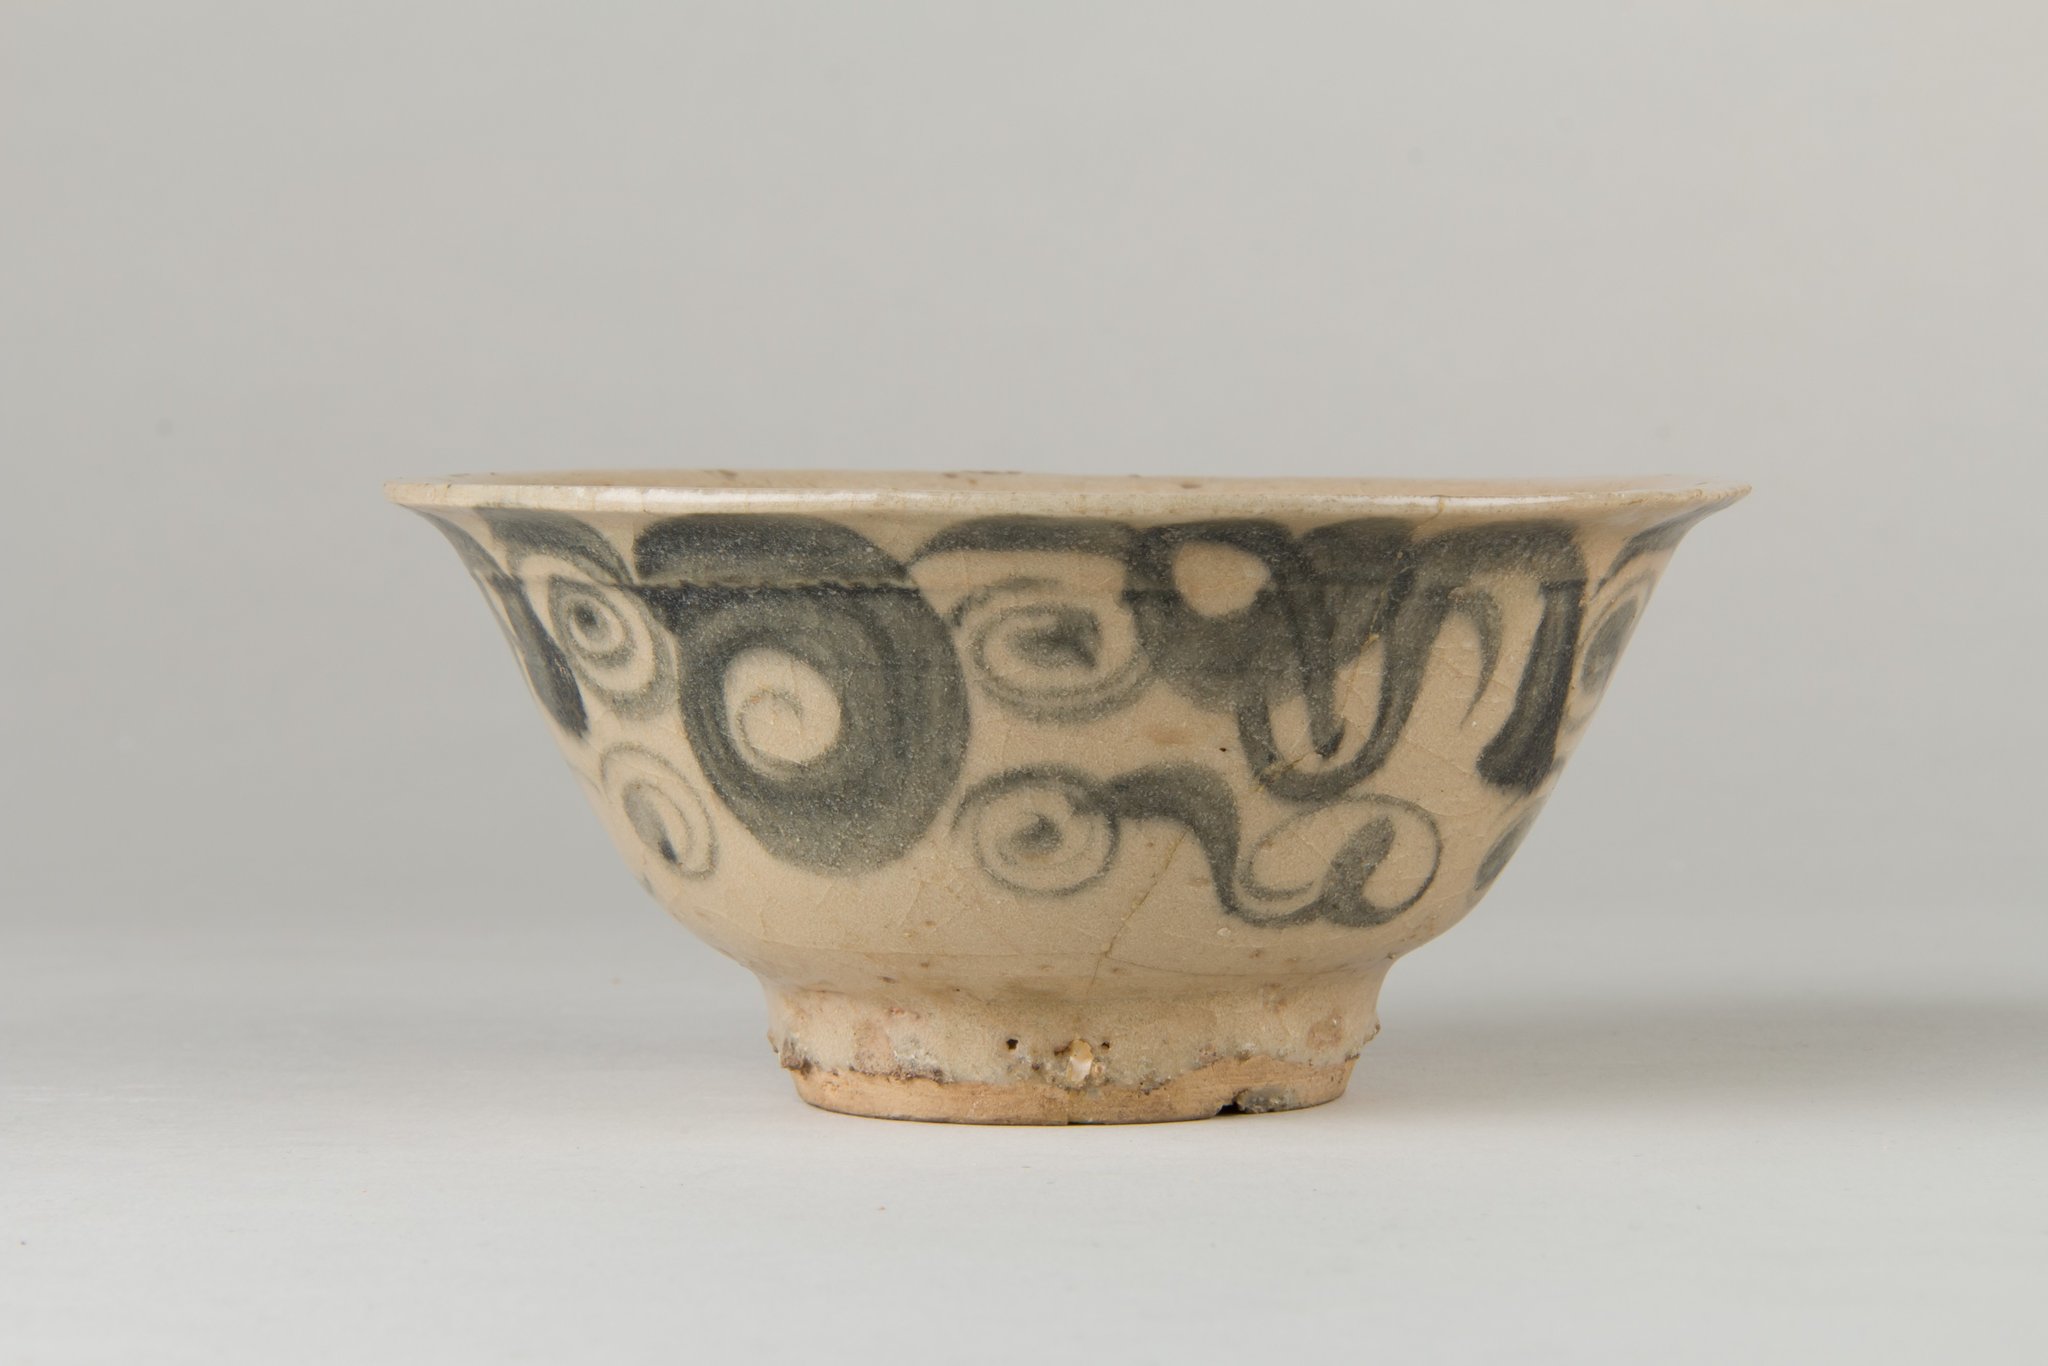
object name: bowl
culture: chinese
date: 1573-1620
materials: pottery